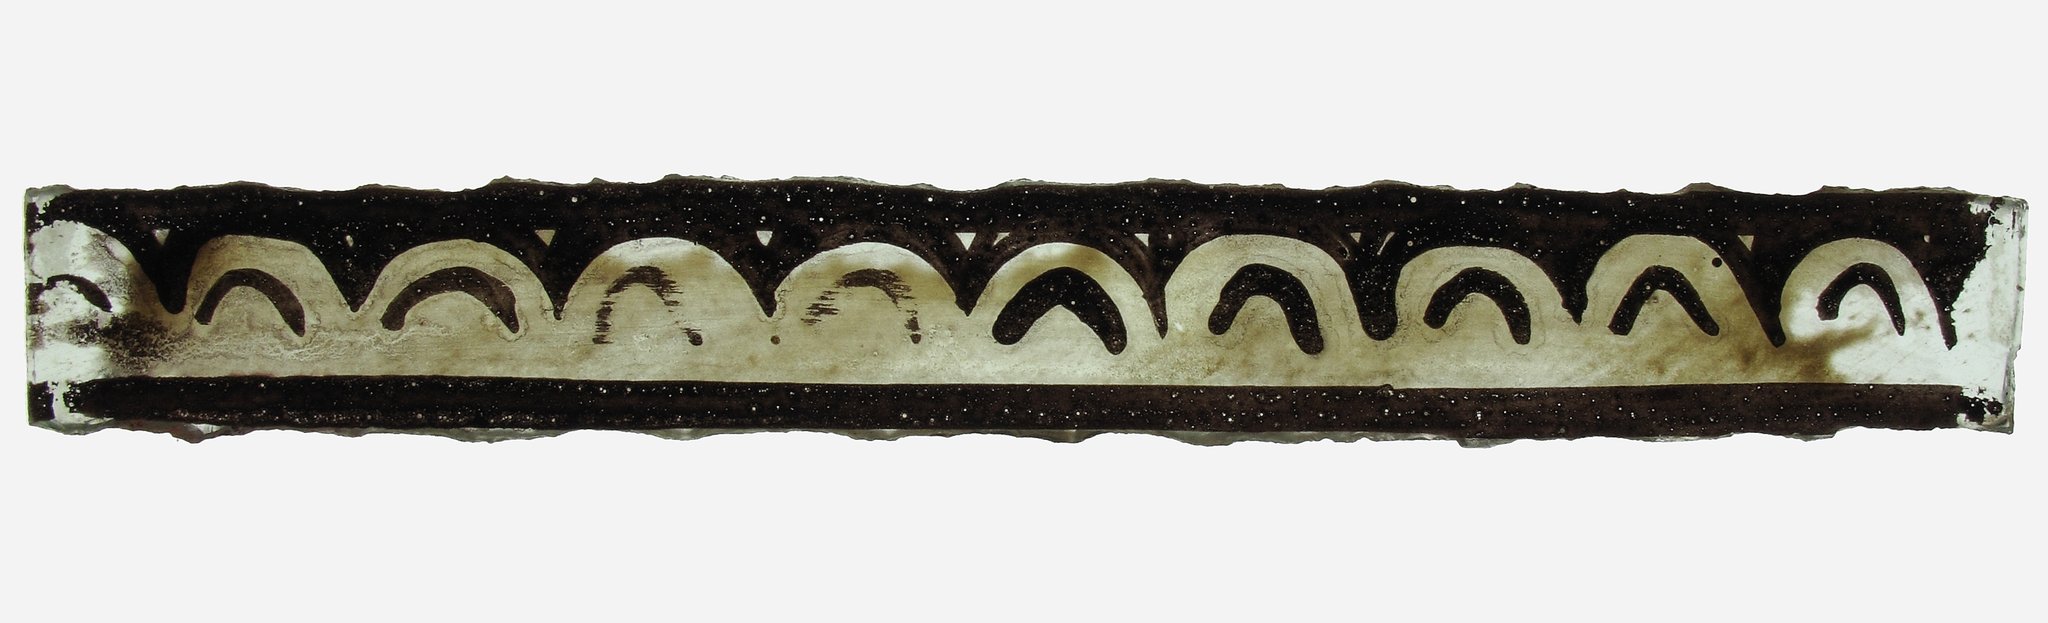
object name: fragment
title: Glass Fragment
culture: european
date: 1301-1500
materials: glass